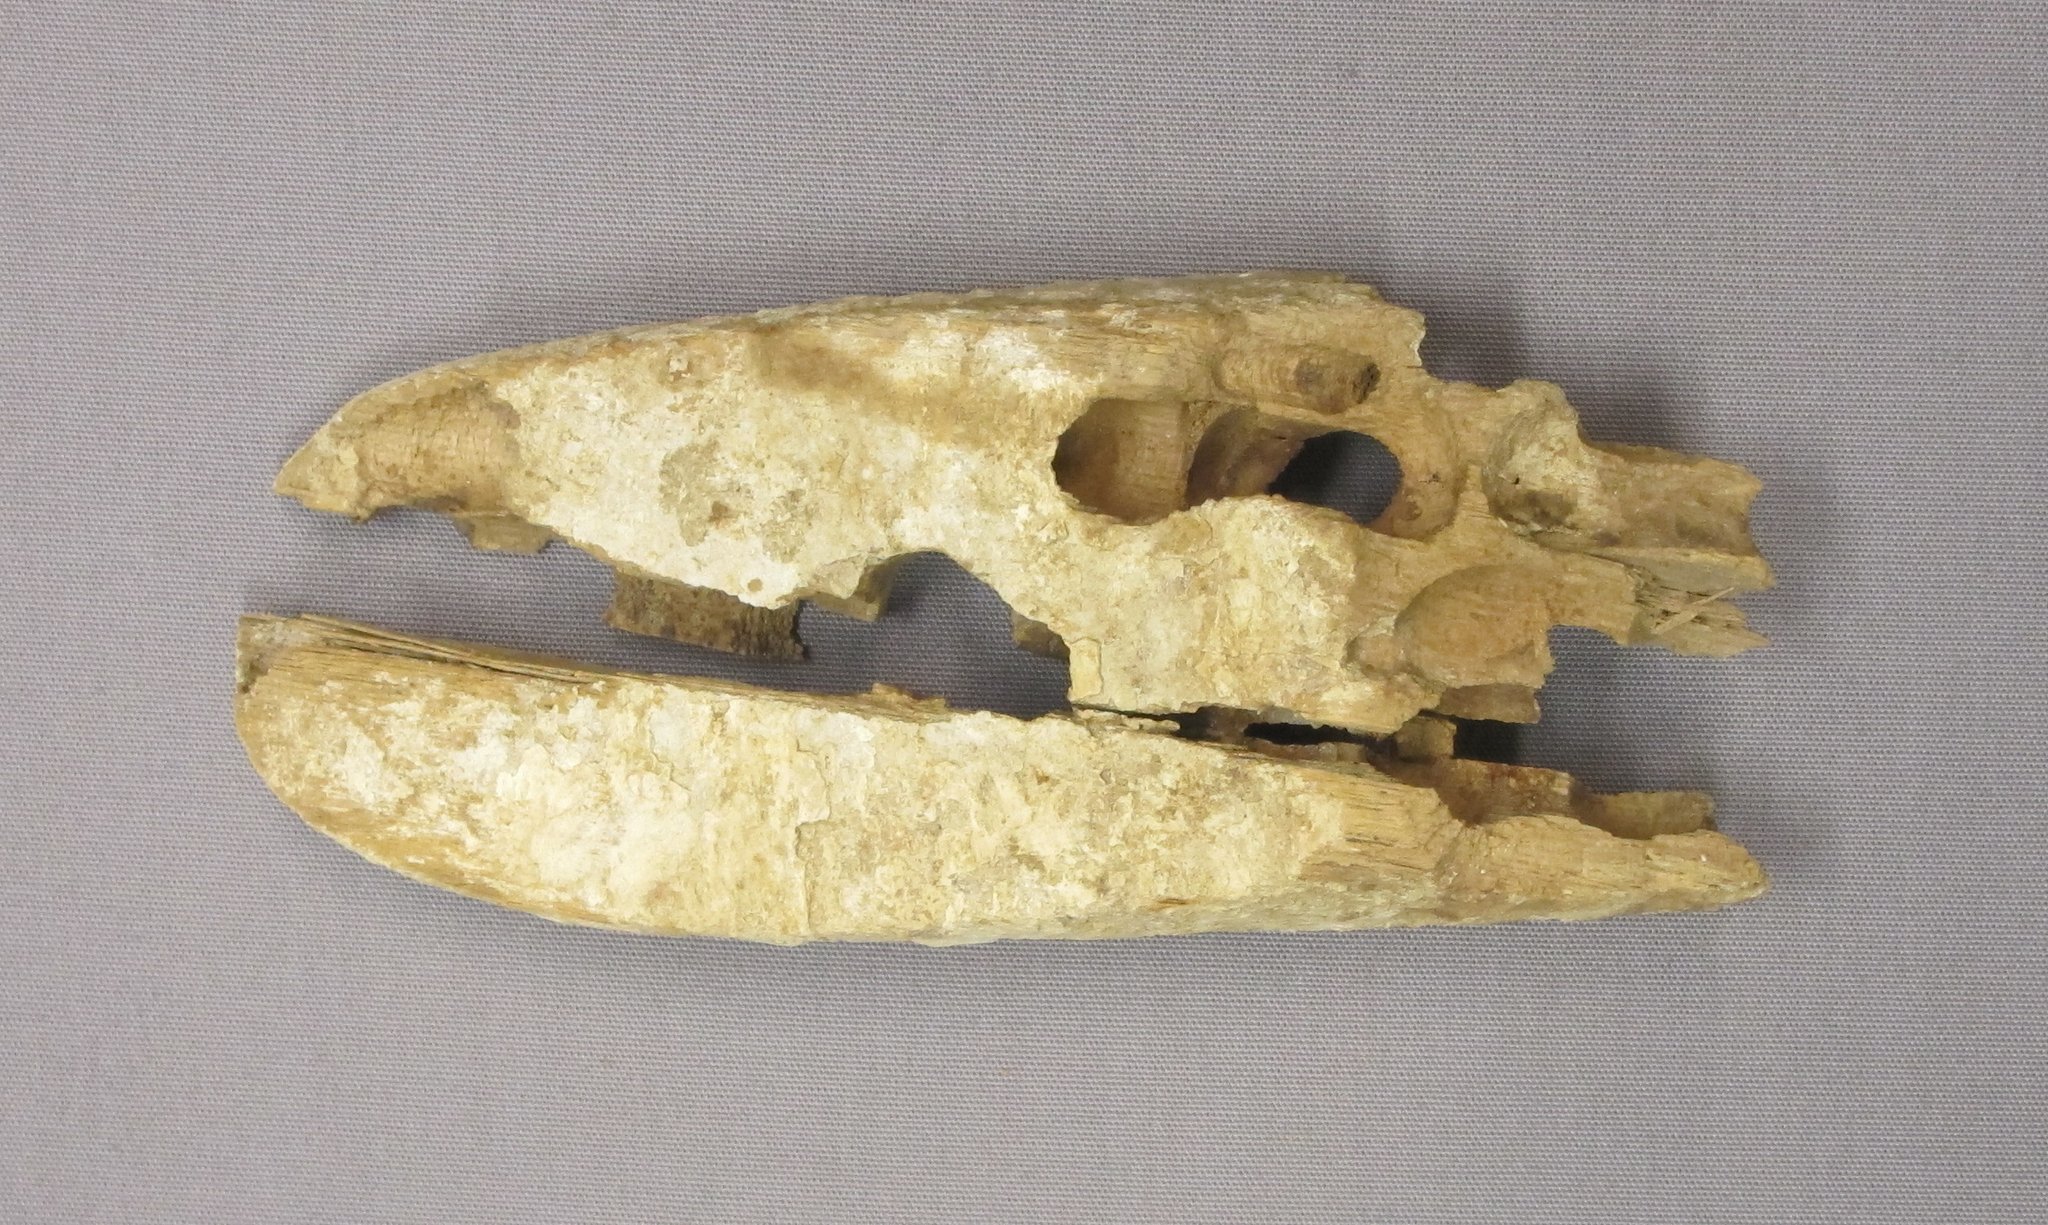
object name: door fragment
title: Fragment from a door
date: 2150-1981 BCE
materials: paint, wood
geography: egypt